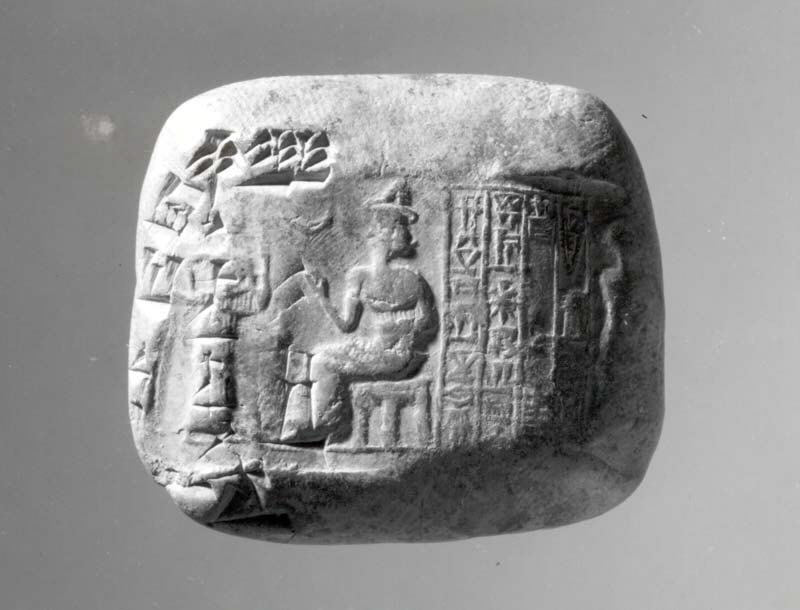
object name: cuneiform tablet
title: Cuneiform tablet impressed with cylinder seal: receipt of goats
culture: neo-sumerian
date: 2040 BCE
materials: clay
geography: mesopotamia